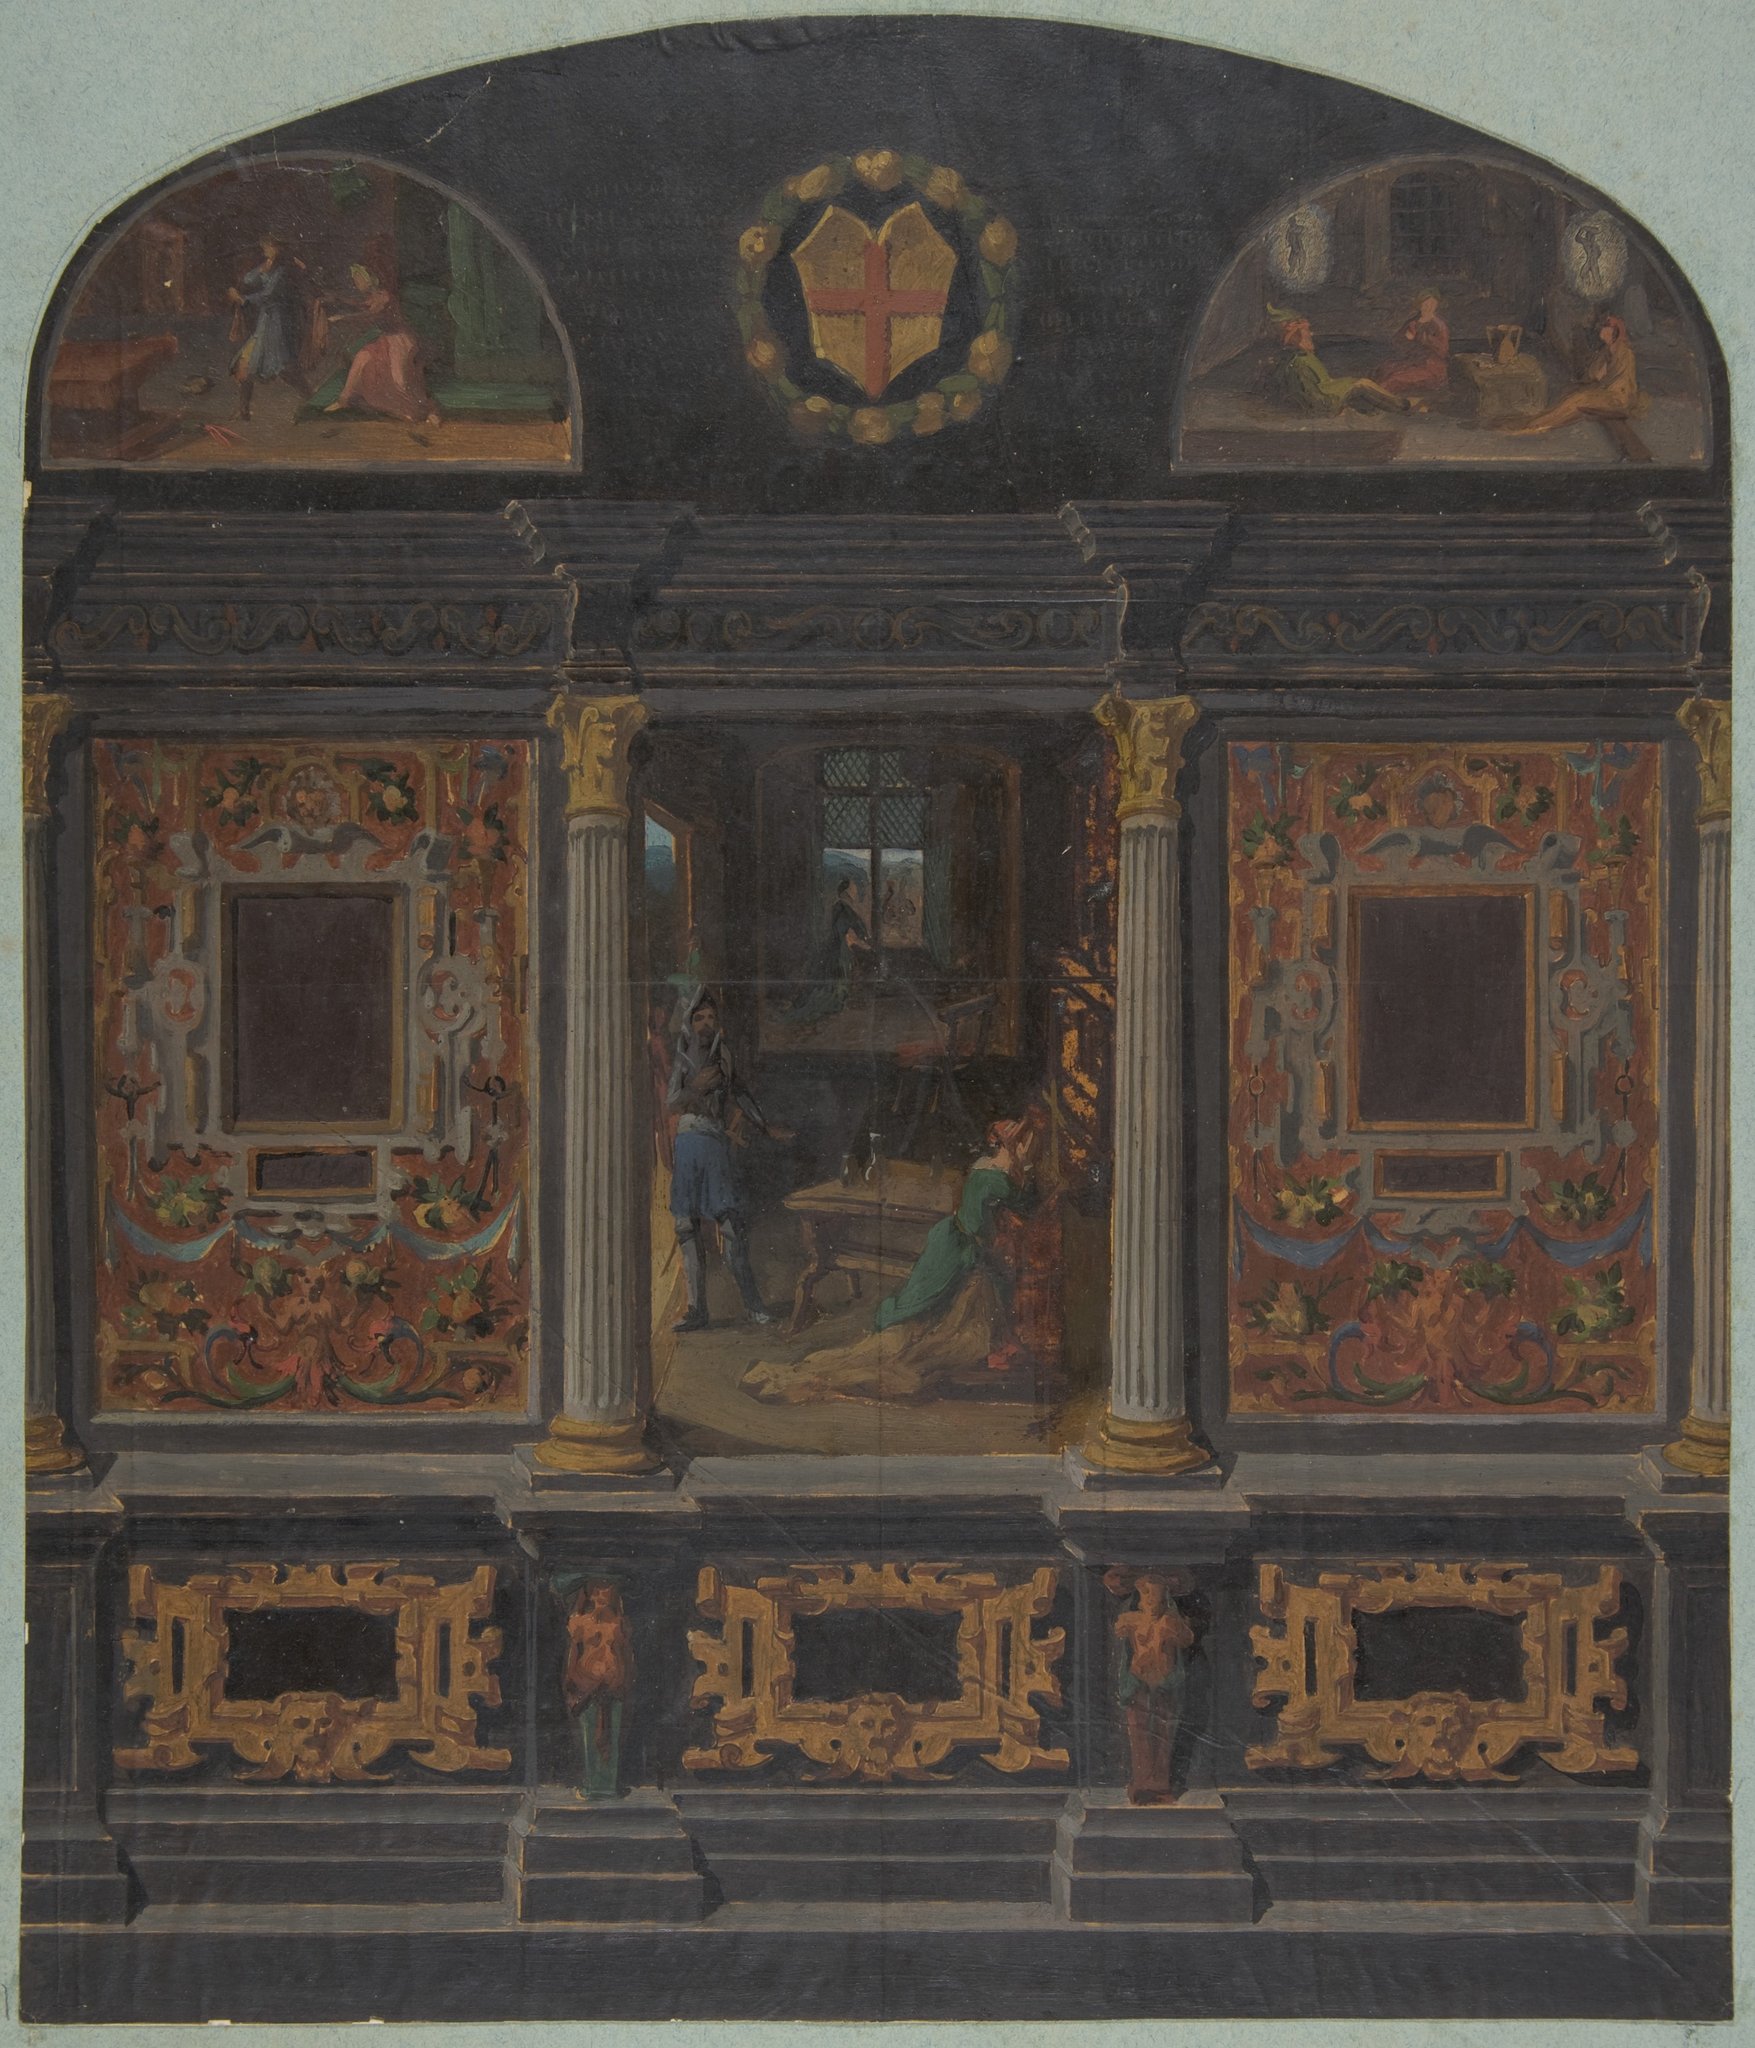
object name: drawing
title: Design for painted wall decoration in the Château de Lude, Sarthe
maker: jules-edmond-charles lachaise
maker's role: artist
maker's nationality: french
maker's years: 1897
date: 1851-1900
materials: gouache, paper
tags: columns,interiors,men,women